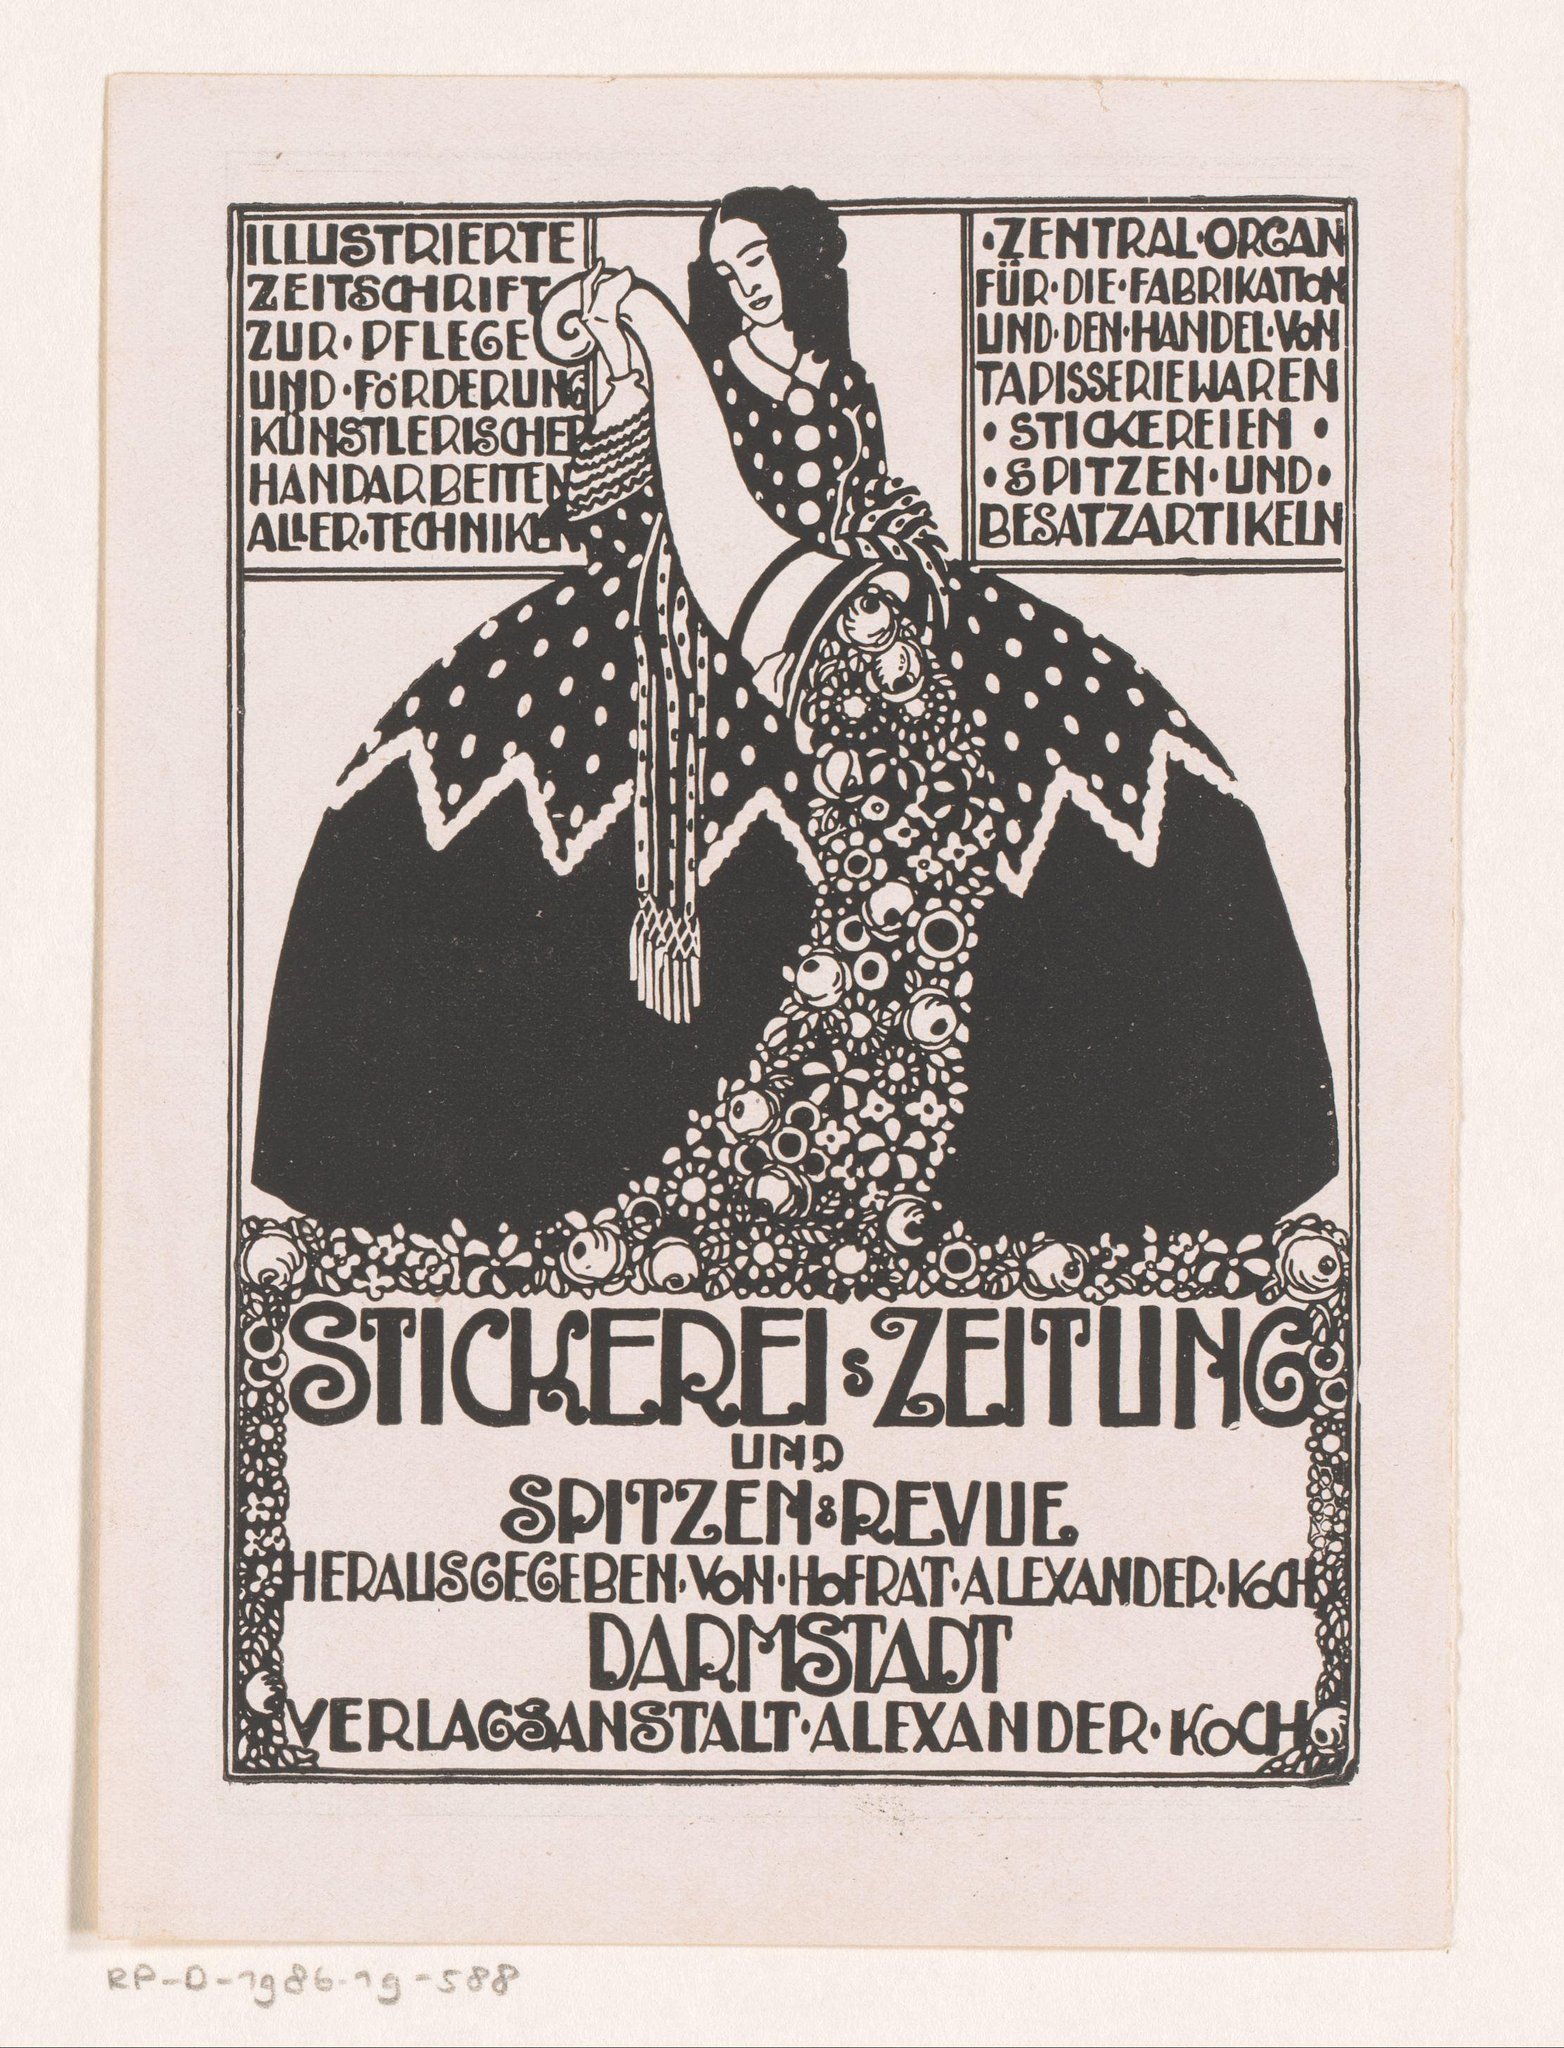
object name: photomechanical print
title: Vrouw met cornucopia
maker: Anonymous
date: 1906-1932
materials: paper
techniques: printing block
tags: 'cornucopia', horn of plenty, dress, gown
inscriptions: collector's mark: ‘R:MVS.’, name: ‘R.W.P. de Vries in Amsterdam, Singel 146’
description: Reproductie van de omslag van de Stickerei-Zeitung und Spitzen-Revue met een vrouw in een lange jurk die een hoorn des overvloeds (cornucopia) vasthoudt waaruit bloemen stromen. Deze stroom vormt een kader om de tekst.